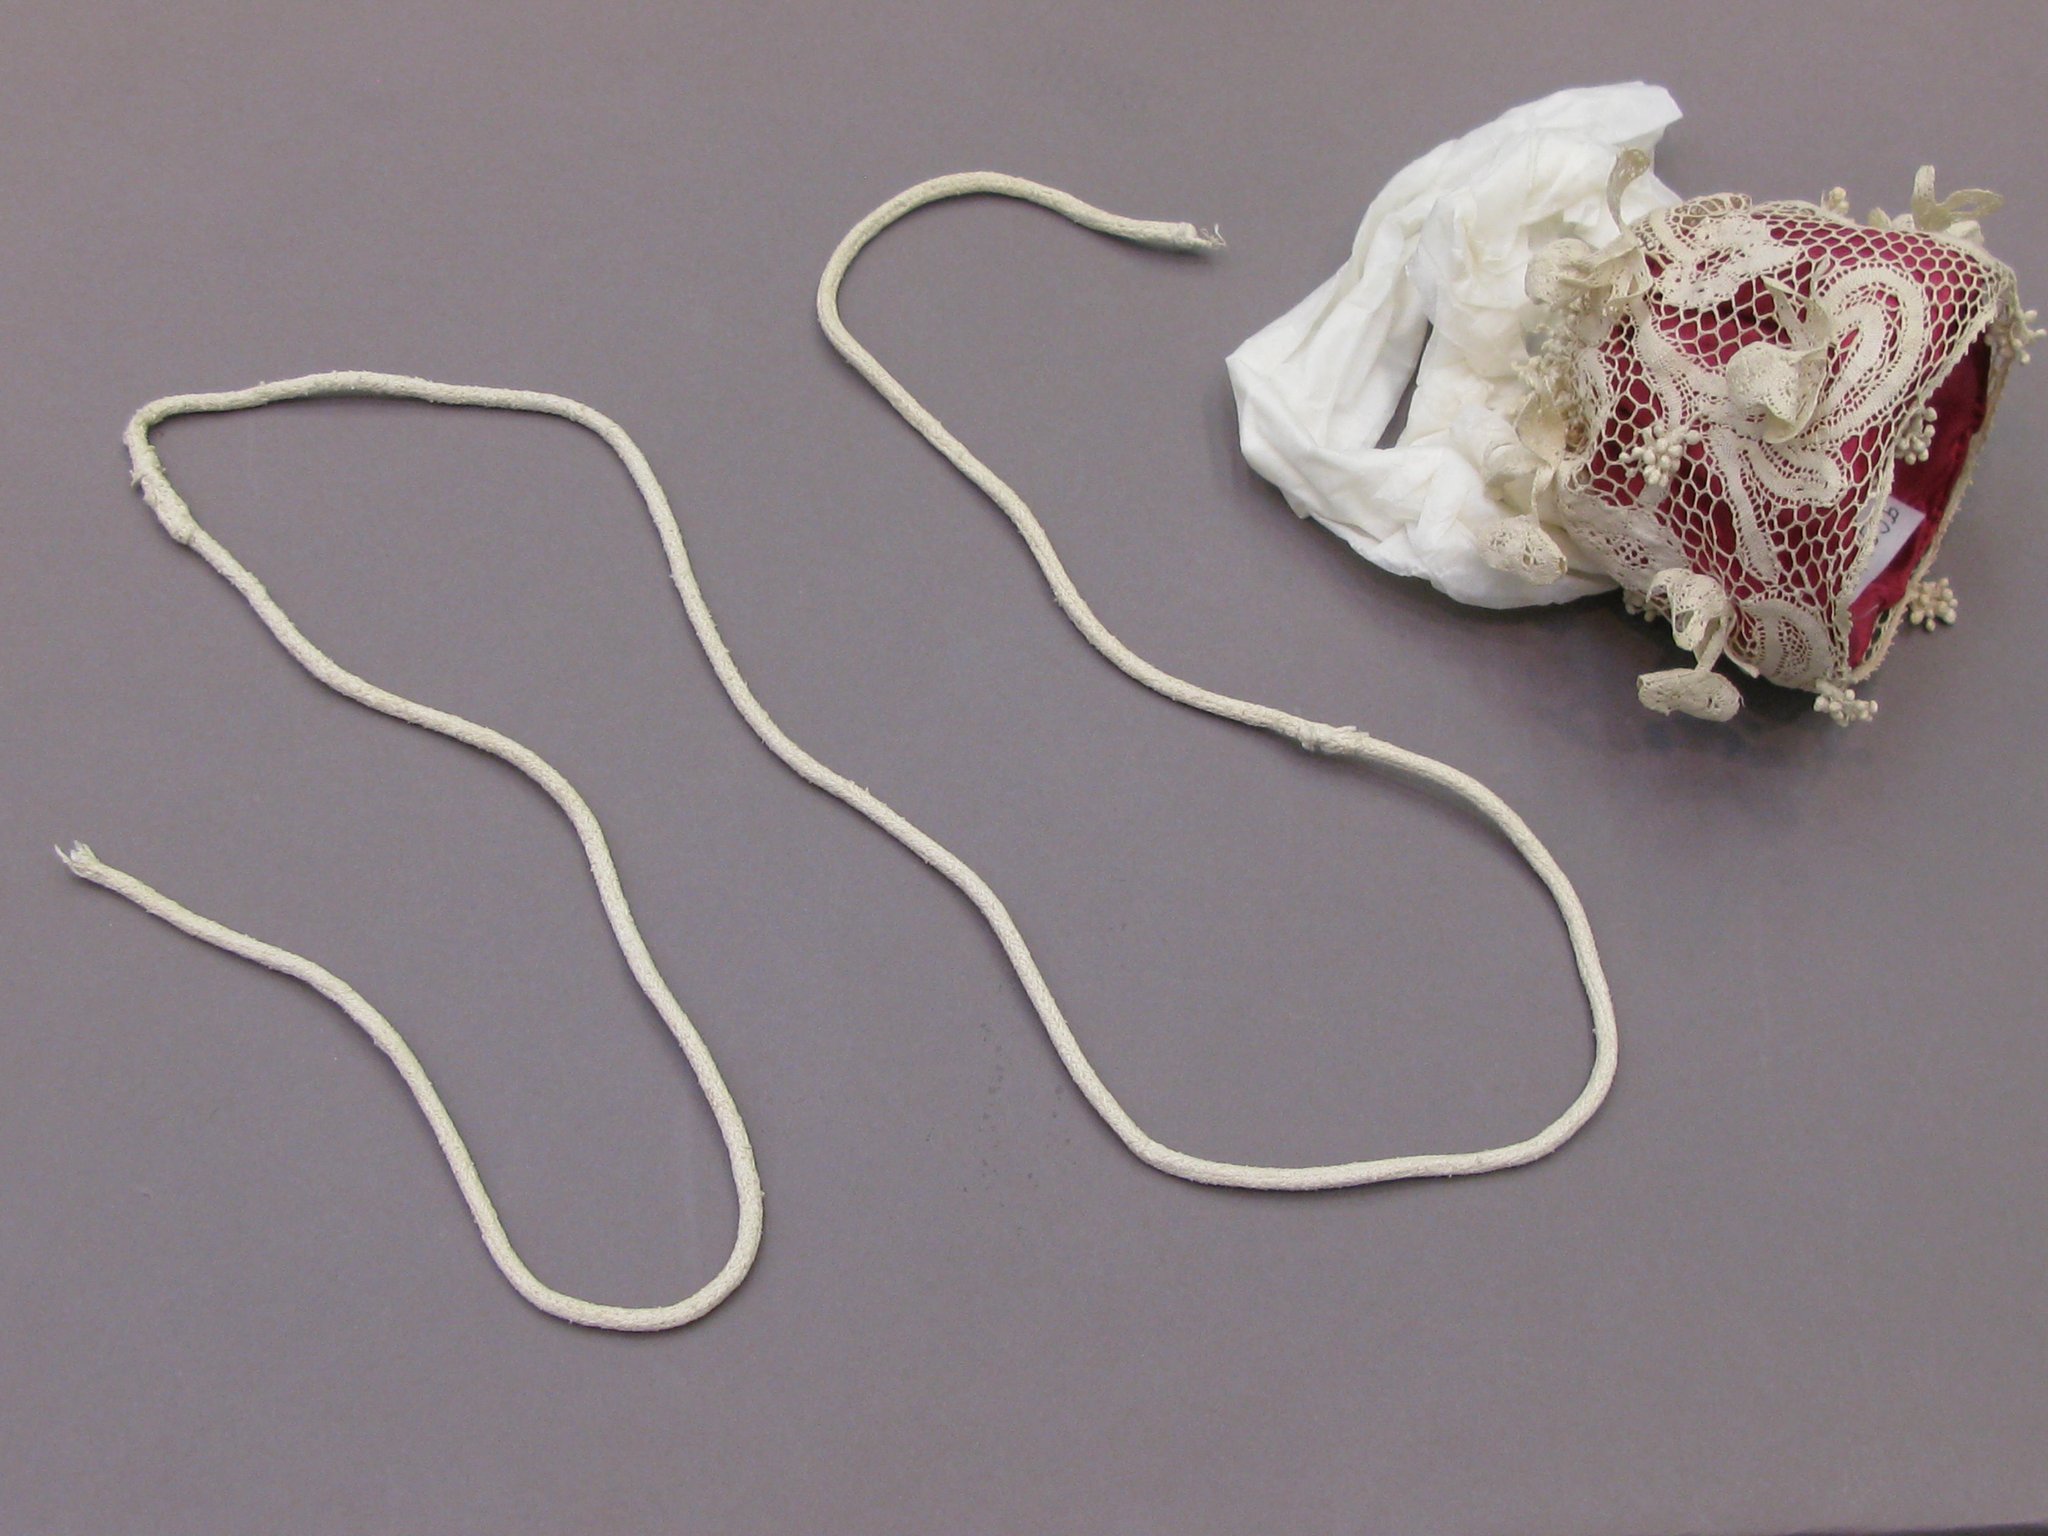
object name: tassel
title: Lace tassel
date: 1601-1700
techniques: lace